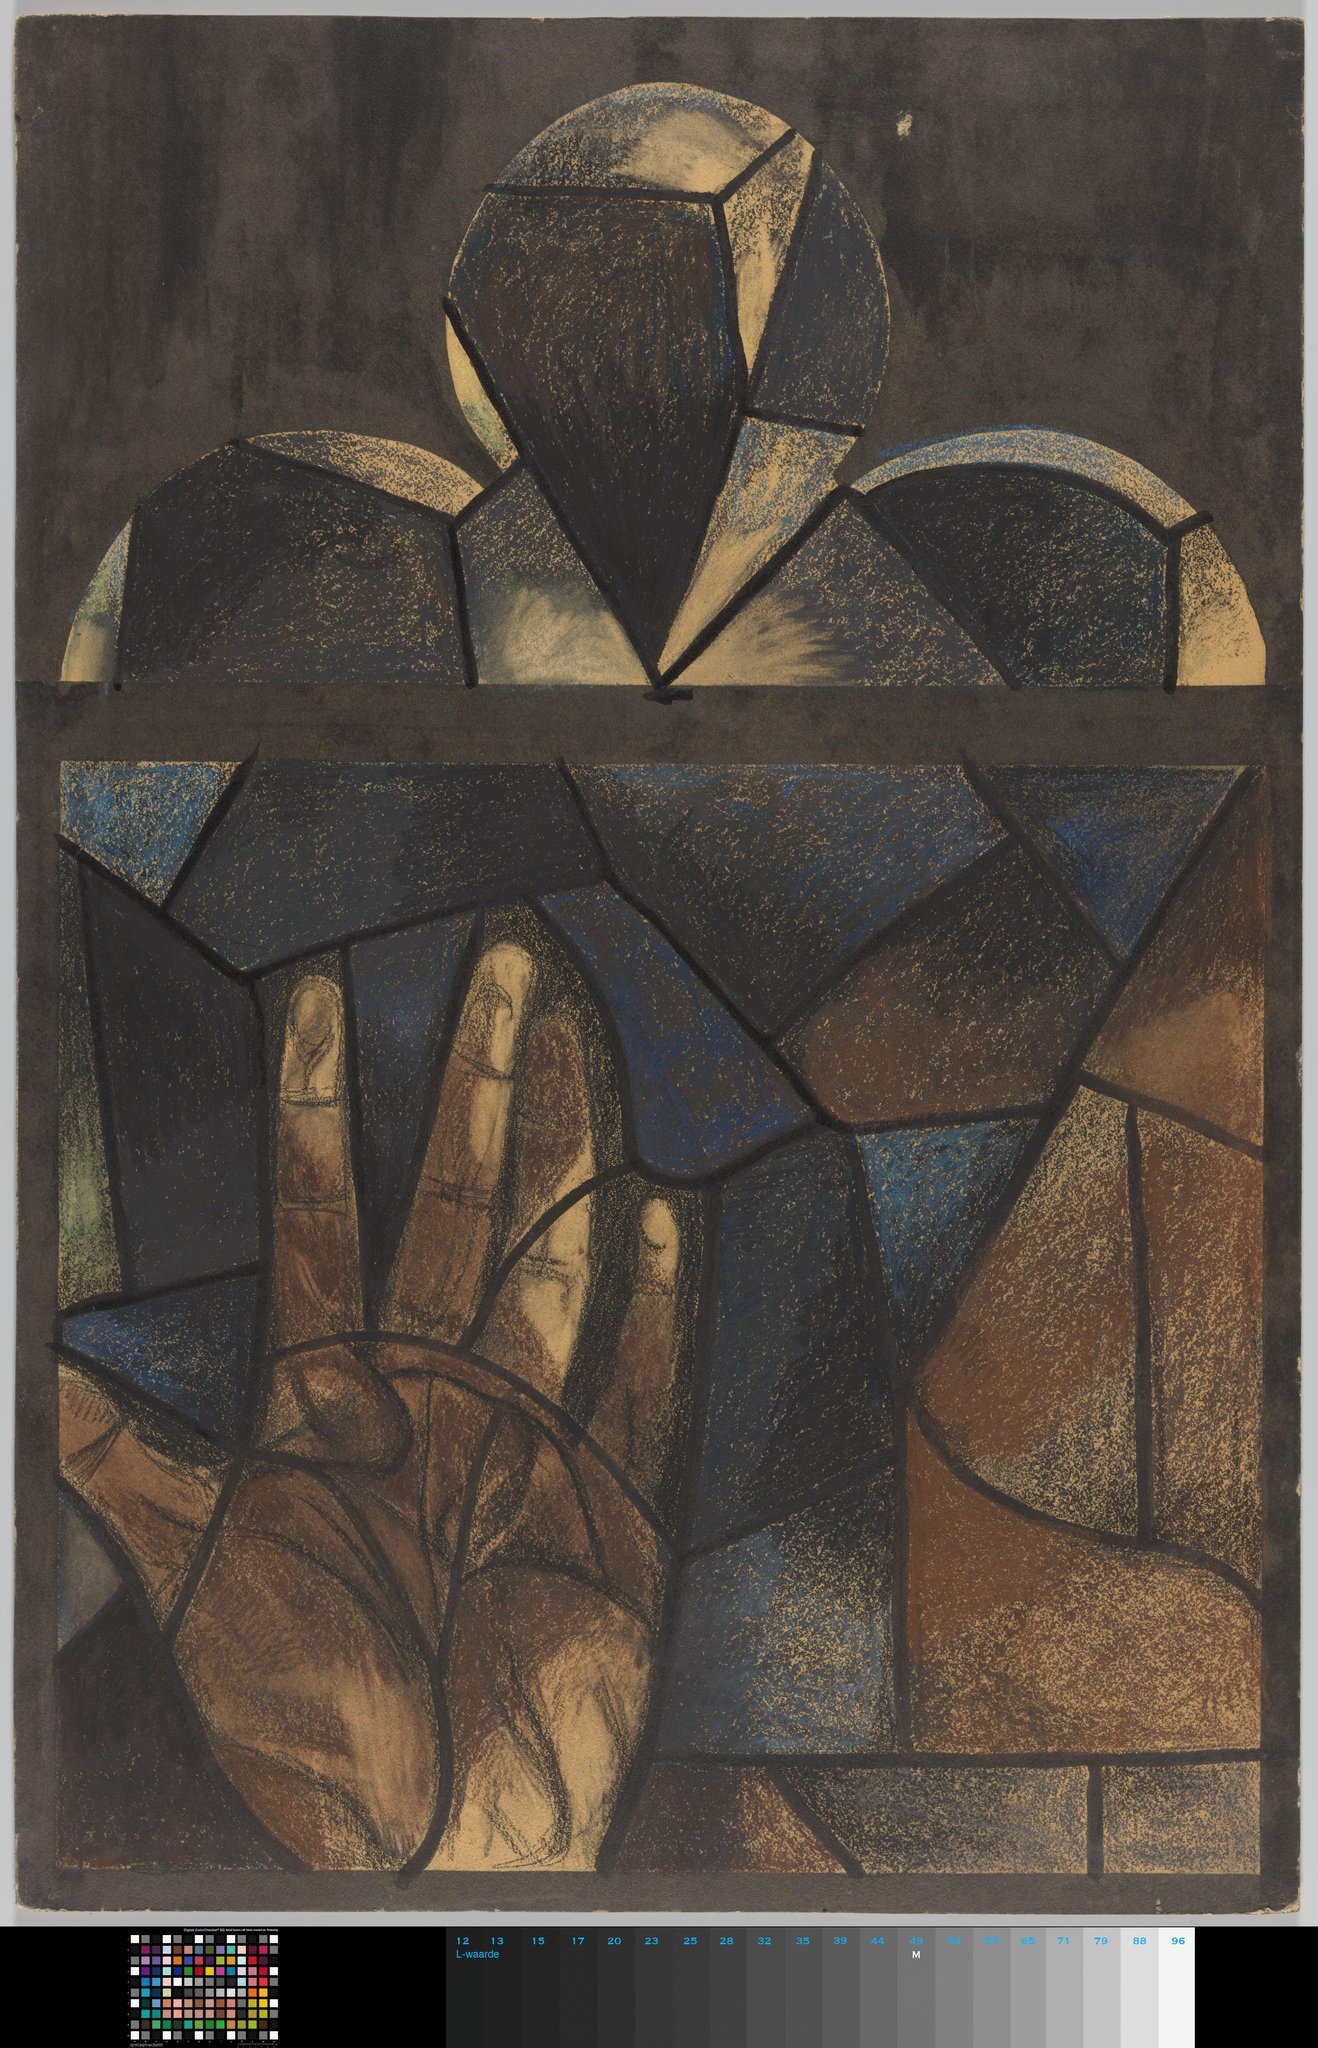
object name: design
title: Ontwerp voor raam in het Noordertransept in de Dom te Utrecht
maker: richard nicolaüs roland holst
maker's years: 1868-1938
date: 1934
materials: cardboard, chalk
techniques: brush